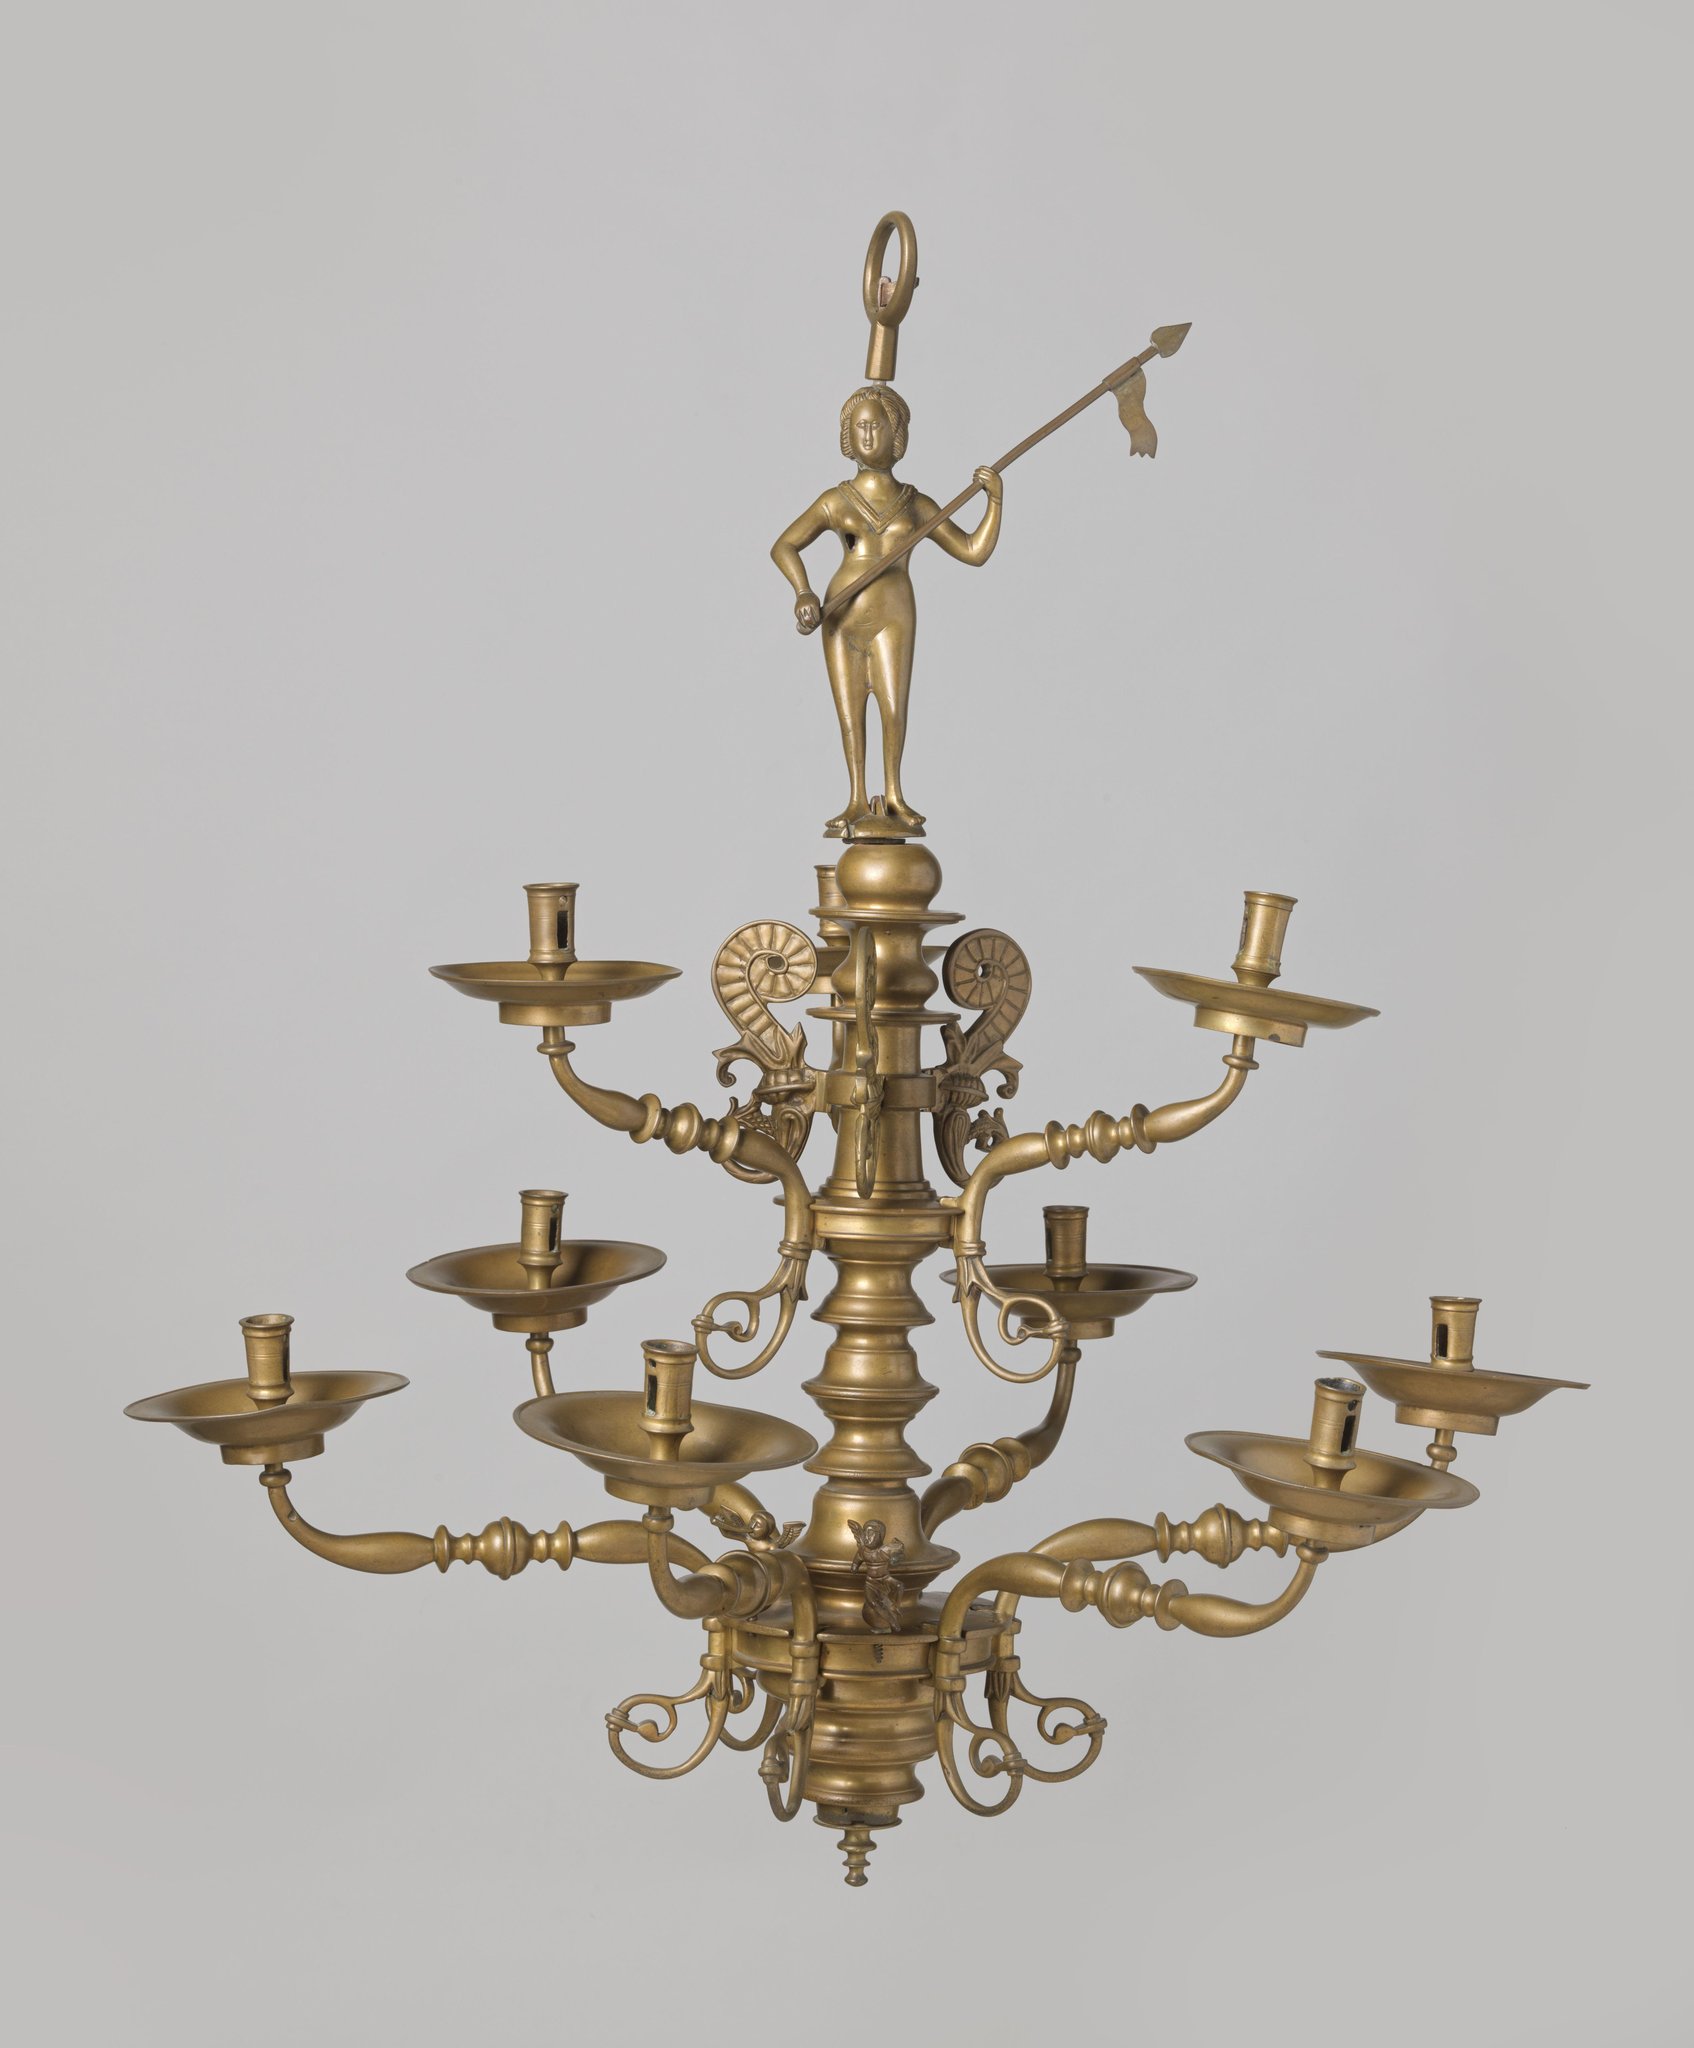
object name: chandelier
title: Stang met figuur van kaarsenkroon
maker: Anonymous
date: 1525-1575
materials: brass, iron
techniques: casting, riveted, screwed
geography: north germany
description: Het voorwerp bestaat uit twee ijzeren stangen, twee koperen spieën en de volgende delen van geel koper: de hangring, de figuur van een naakte vrouw met speer en vaantje. De ronde hangring gaat onderaan over in een achtvlakkig buisstuk. De staande naakte vrouwenfiguur staat op een grondje met in het midden een gat (teneinde een spie in de ijzeren stang te kunnen bevestigen) en een inkeping aan de rand. Zij houdt een speer met een vaantje op. Om haar hals draagt zij een keten(?). Het haar is om haar hoofd gedrapeerd. Op het hoofd is een korte ijzeren stang aangebracht, waarop de hangring past. De stam is bol- en holrond geprofileerd met bovenaan een standring met inkepingen voor de drie sierstukken, dan een standring met inkepingen voor de drie bovenste armen, vervolgens een standring met inkepingen voor de onderste zes armen en met zes gaten ter plaatsing van de op een bol gezeten bazuinenengeltjes. Alle inkepingen en gaten zijn gemerkt met één, twee of meer driehoekige markeringen. In het onderste zich versmallende eind van de stam zijn drie gaten geboord en is een ijzeren ring met behulp van twee nokken geklonken. Hiermee rust de stam op de aan de stang bevestigde geprofileerde knop. Het hoofd van de vrouw is gebroken en opnieuw aangebracht. De speer, die mogelijk later is, is in haar handen vastgeklonken. De leeuwenkop met de trekring die onder de stam behoort te zijn bevestigd, is vervangen door een geprofileerde knop, die aan een geïmproviseerde ijzeren stang is geschroefd. Ook de spieën zijn vernieuwd.